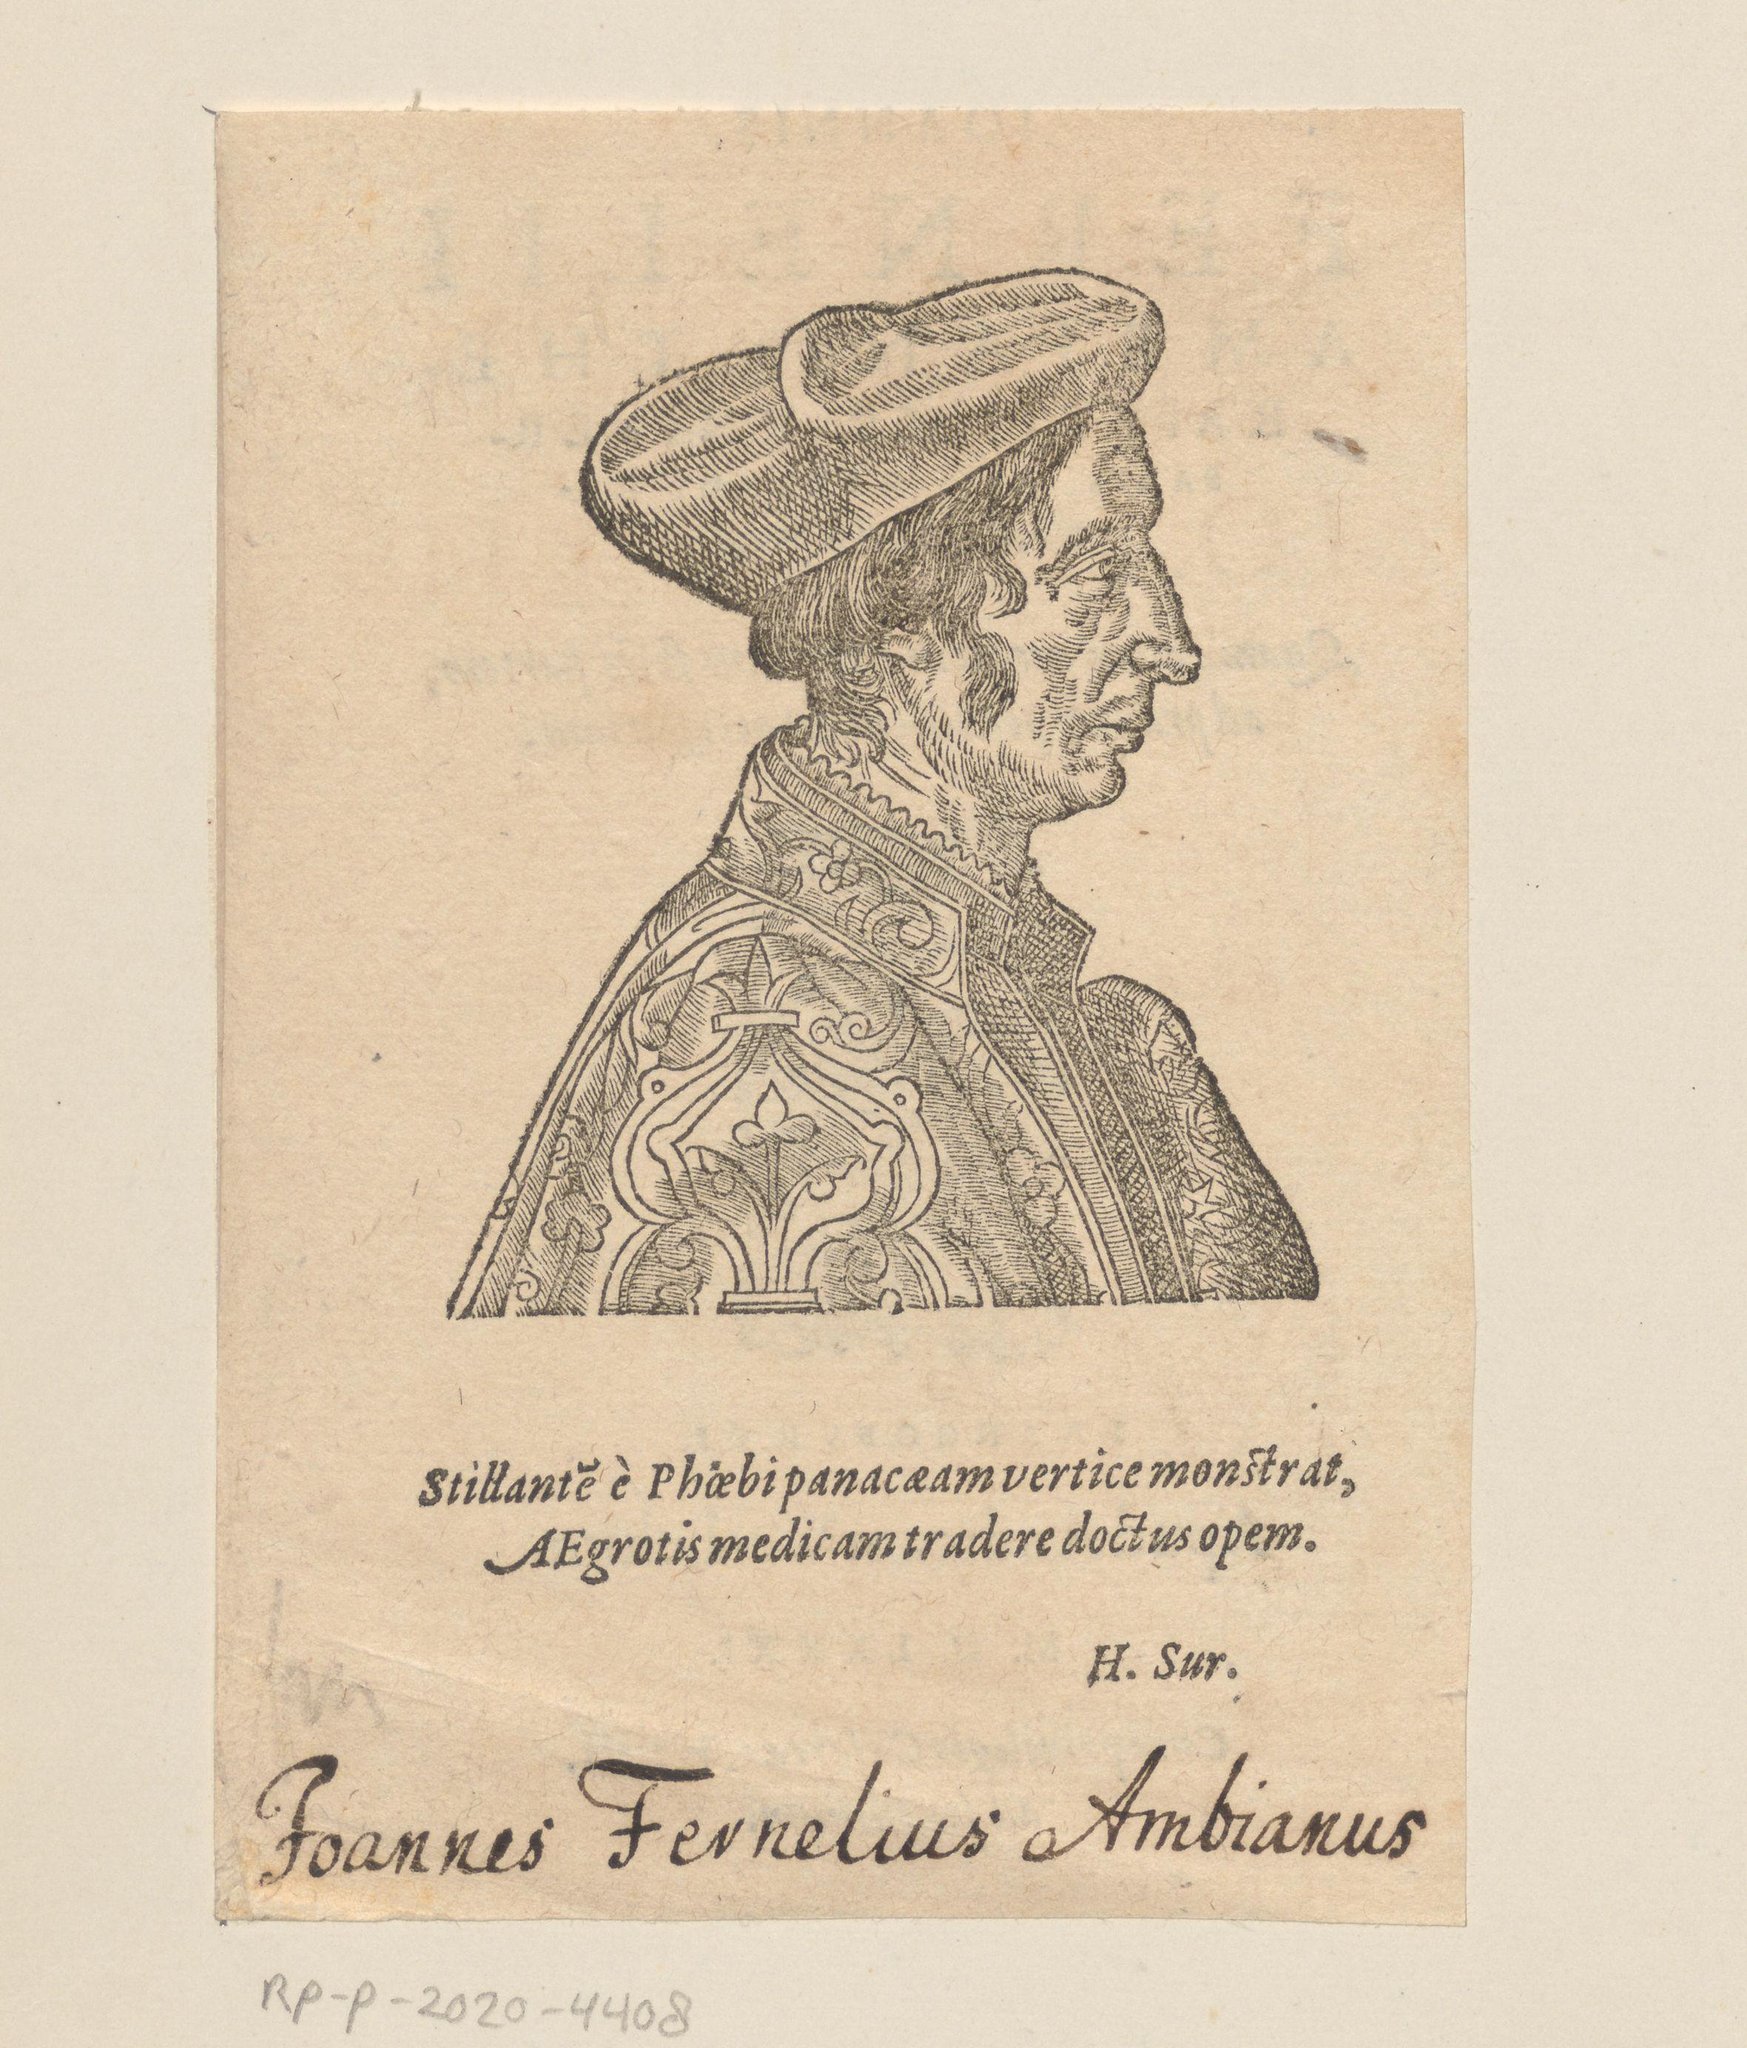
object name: book illustration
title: Portret van Jean François Fernel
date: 1581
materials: paper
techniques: letterpress printing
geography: frankfurt am main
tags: historical persons, title-page, physician, doctor (+ portrait of scholar, scientist), vignette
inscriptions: inscription: ‘Joannes Fernelius Ambianus’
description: Het verso van de prent is de titelpagina. Prent uit: Fernel, Jean François. Therapeutices universalis (...). Frankfurt: André Wechel, 1581.